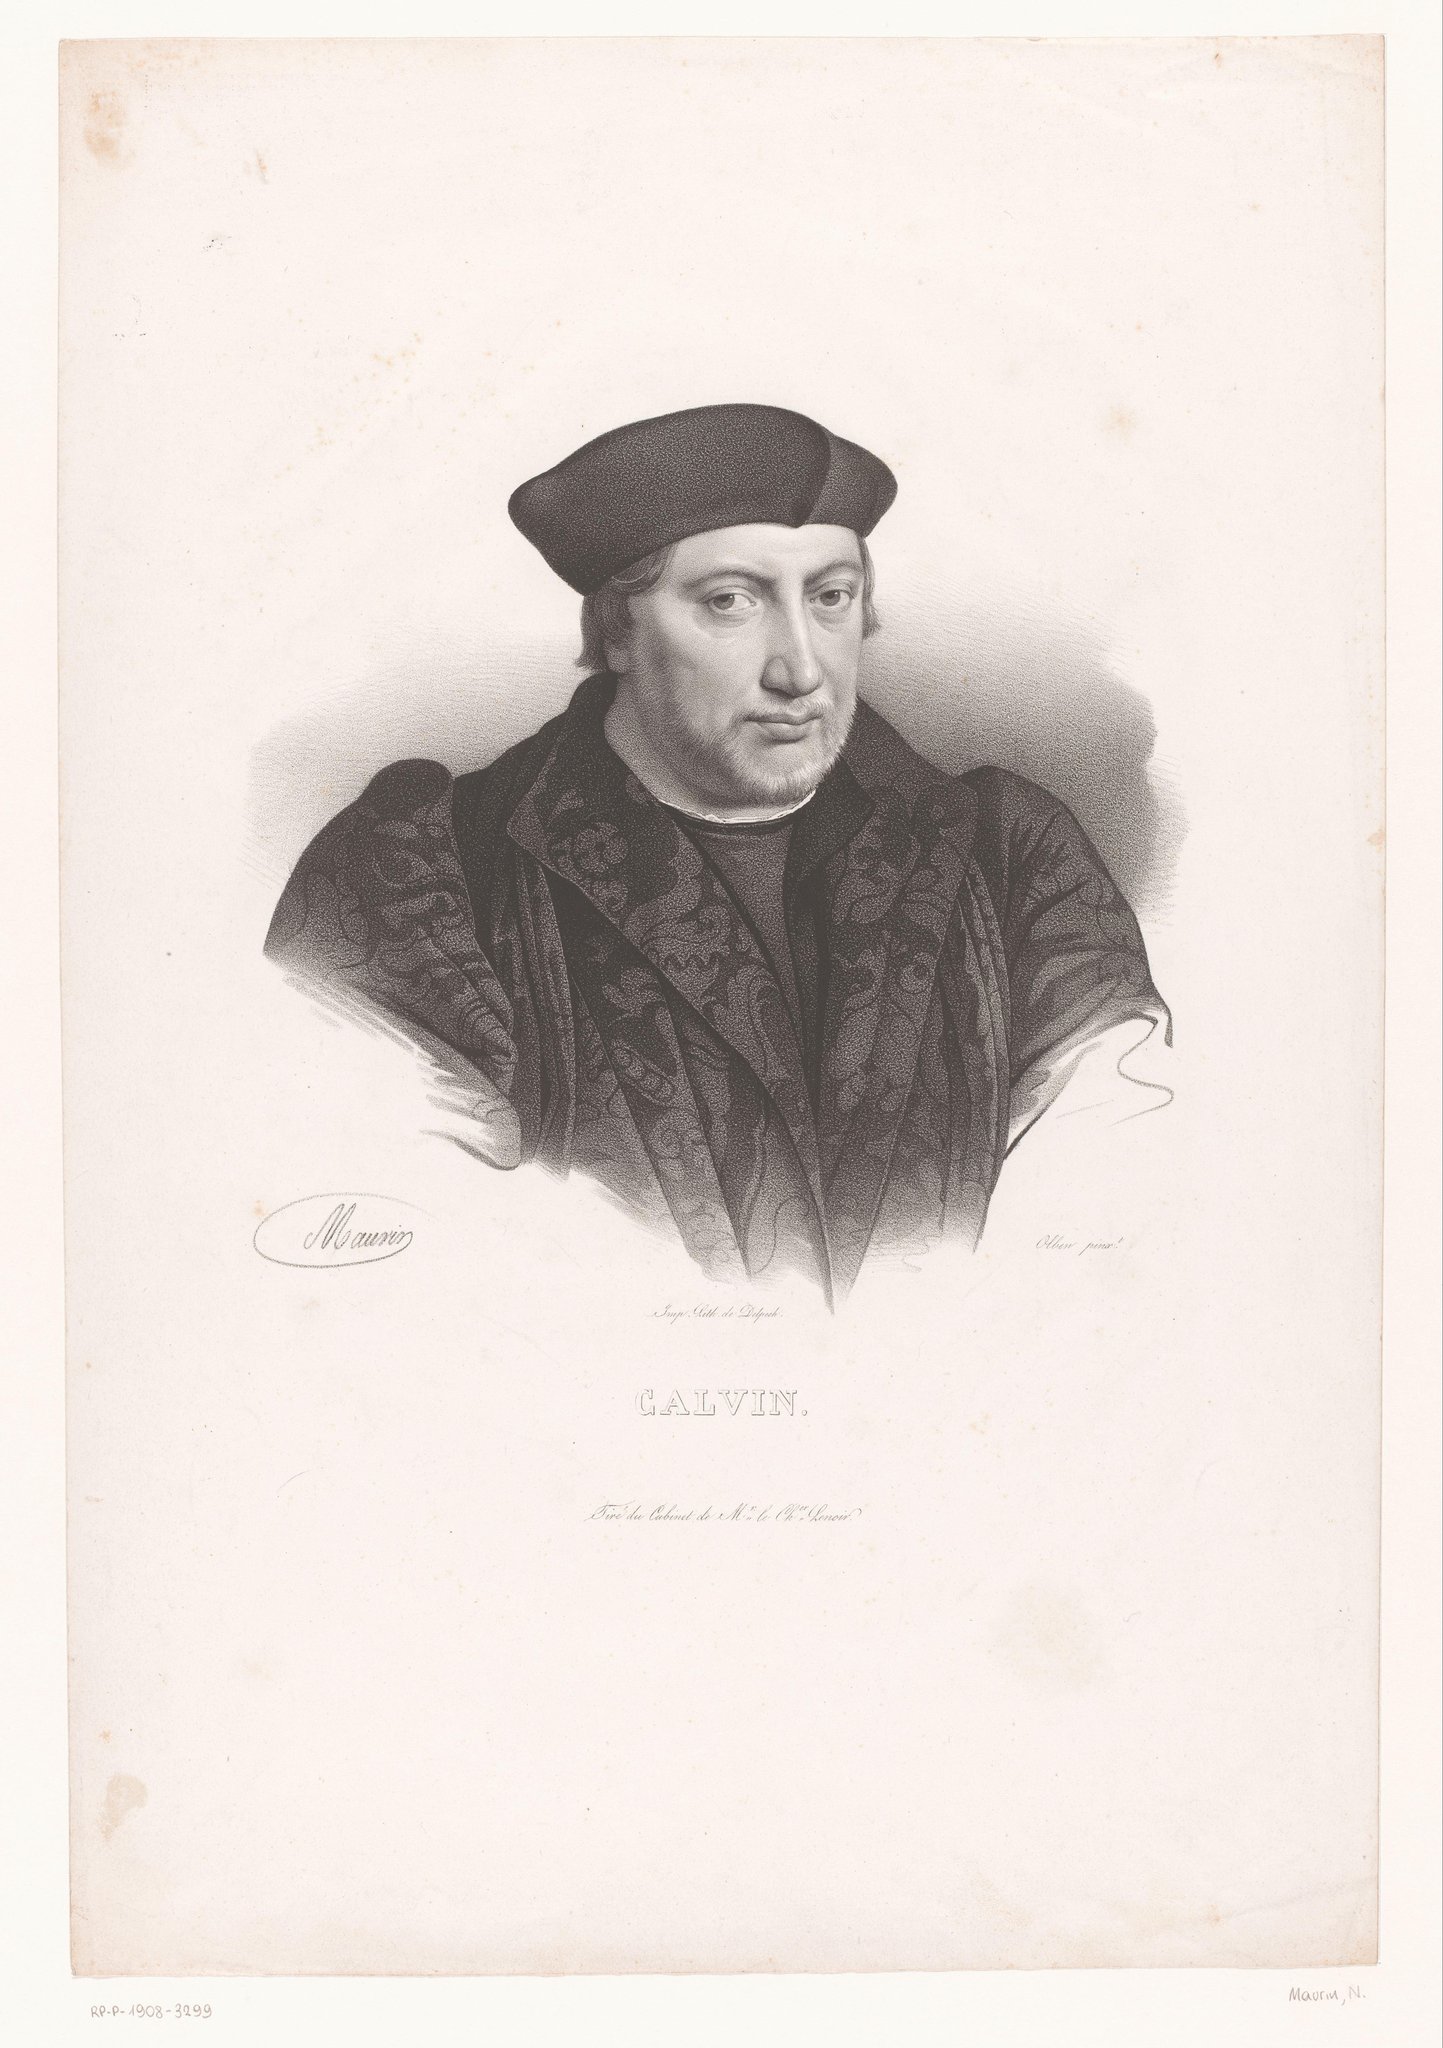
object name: print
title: Calvin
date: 1825-1842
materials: paper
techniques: lithograph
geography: paris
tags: theologian, historical persons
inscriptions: collector's mark: Lugt 2228